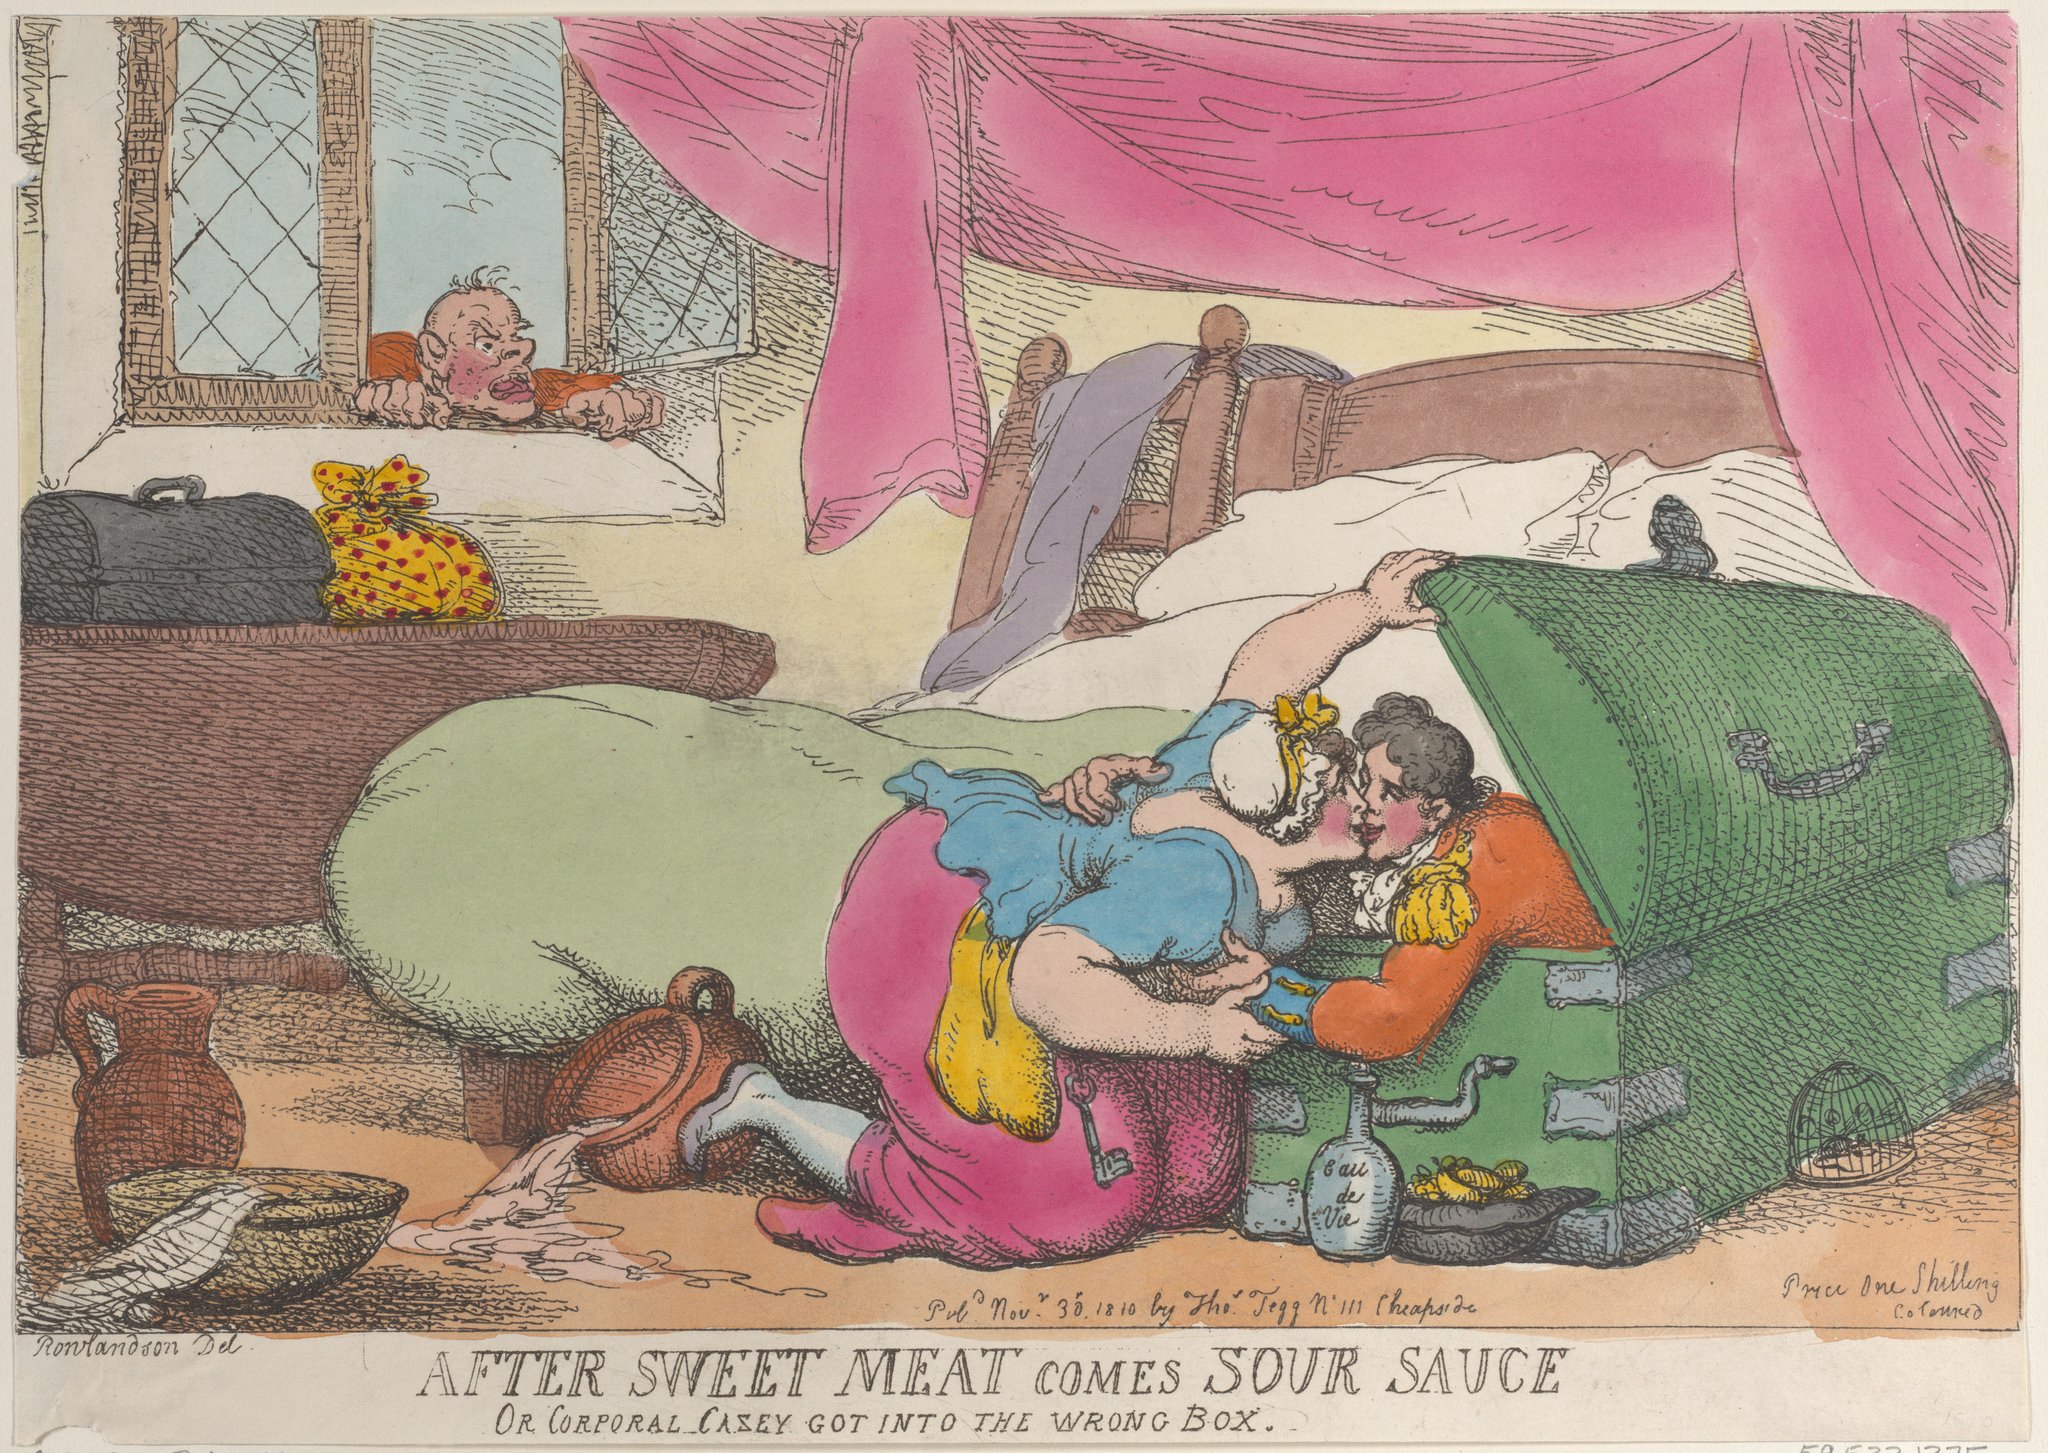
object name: print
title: After Sweet Meat Comes Sour Sauce, or Corporal Casey Got into the Wrong Box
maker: thomas rowlandson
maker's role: artist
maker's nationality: british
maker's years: 1757-1827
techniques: etching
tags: satire,bedrooms,couples,men,women